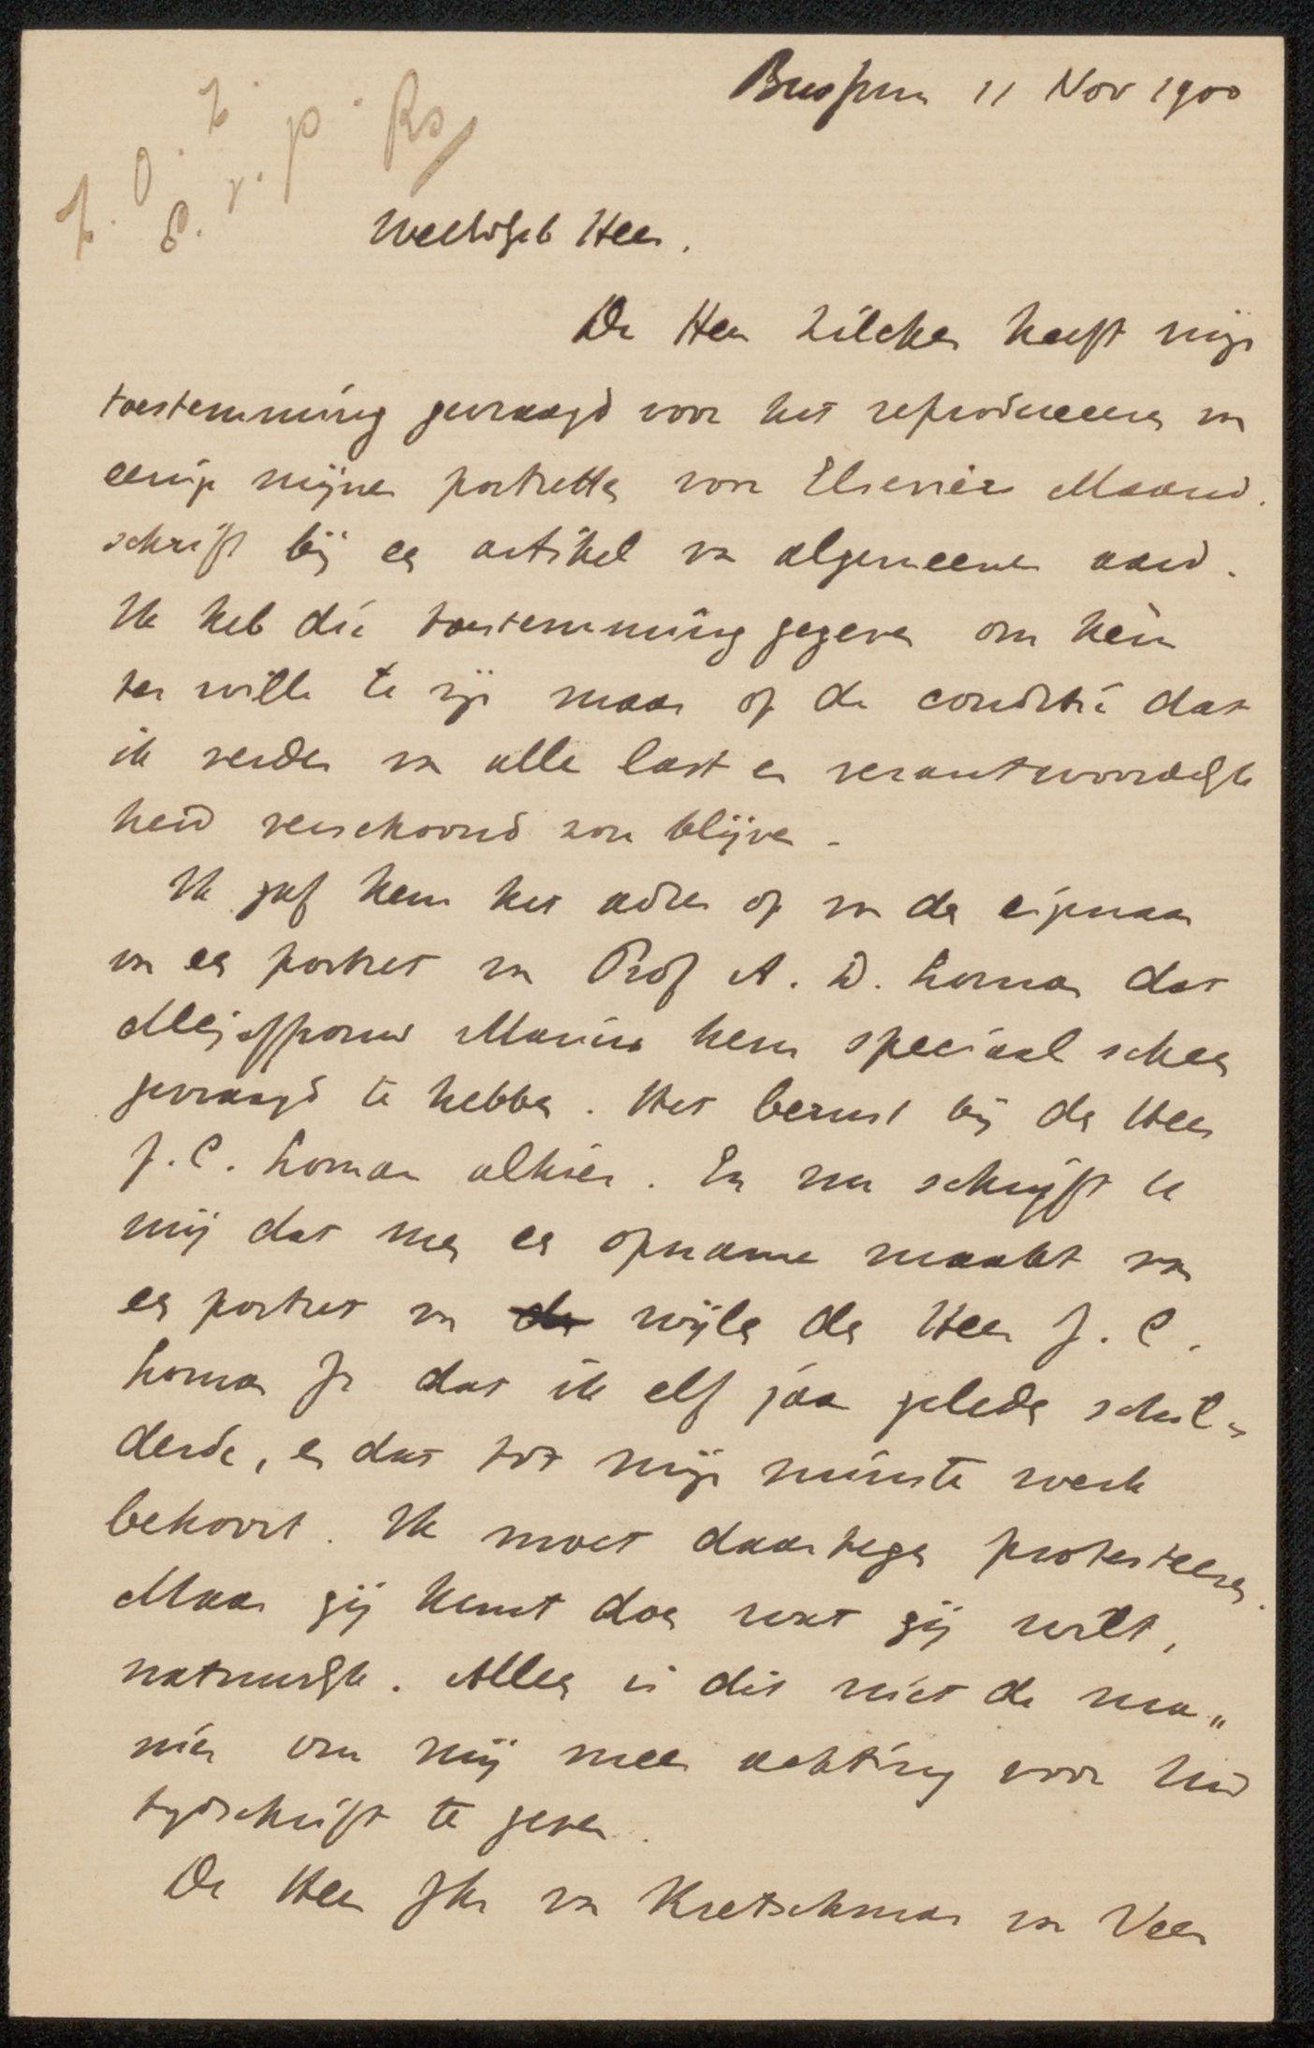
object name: letter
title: Brief aan de redactie van Elsevier's Geïllustreerd Maandschrift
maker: jan veth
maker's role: designer, draughtsman, painter, print maker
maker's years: 1864-1925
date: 1900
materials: ink, paper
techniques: pen, writing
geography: bussum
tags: berlin, wilhelm von bode, the hague, painter, grada hermina marius, philip zilcken, historical persons (portraits and scenes from the life)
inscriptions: collector's mark: ‘RPK’, watermark